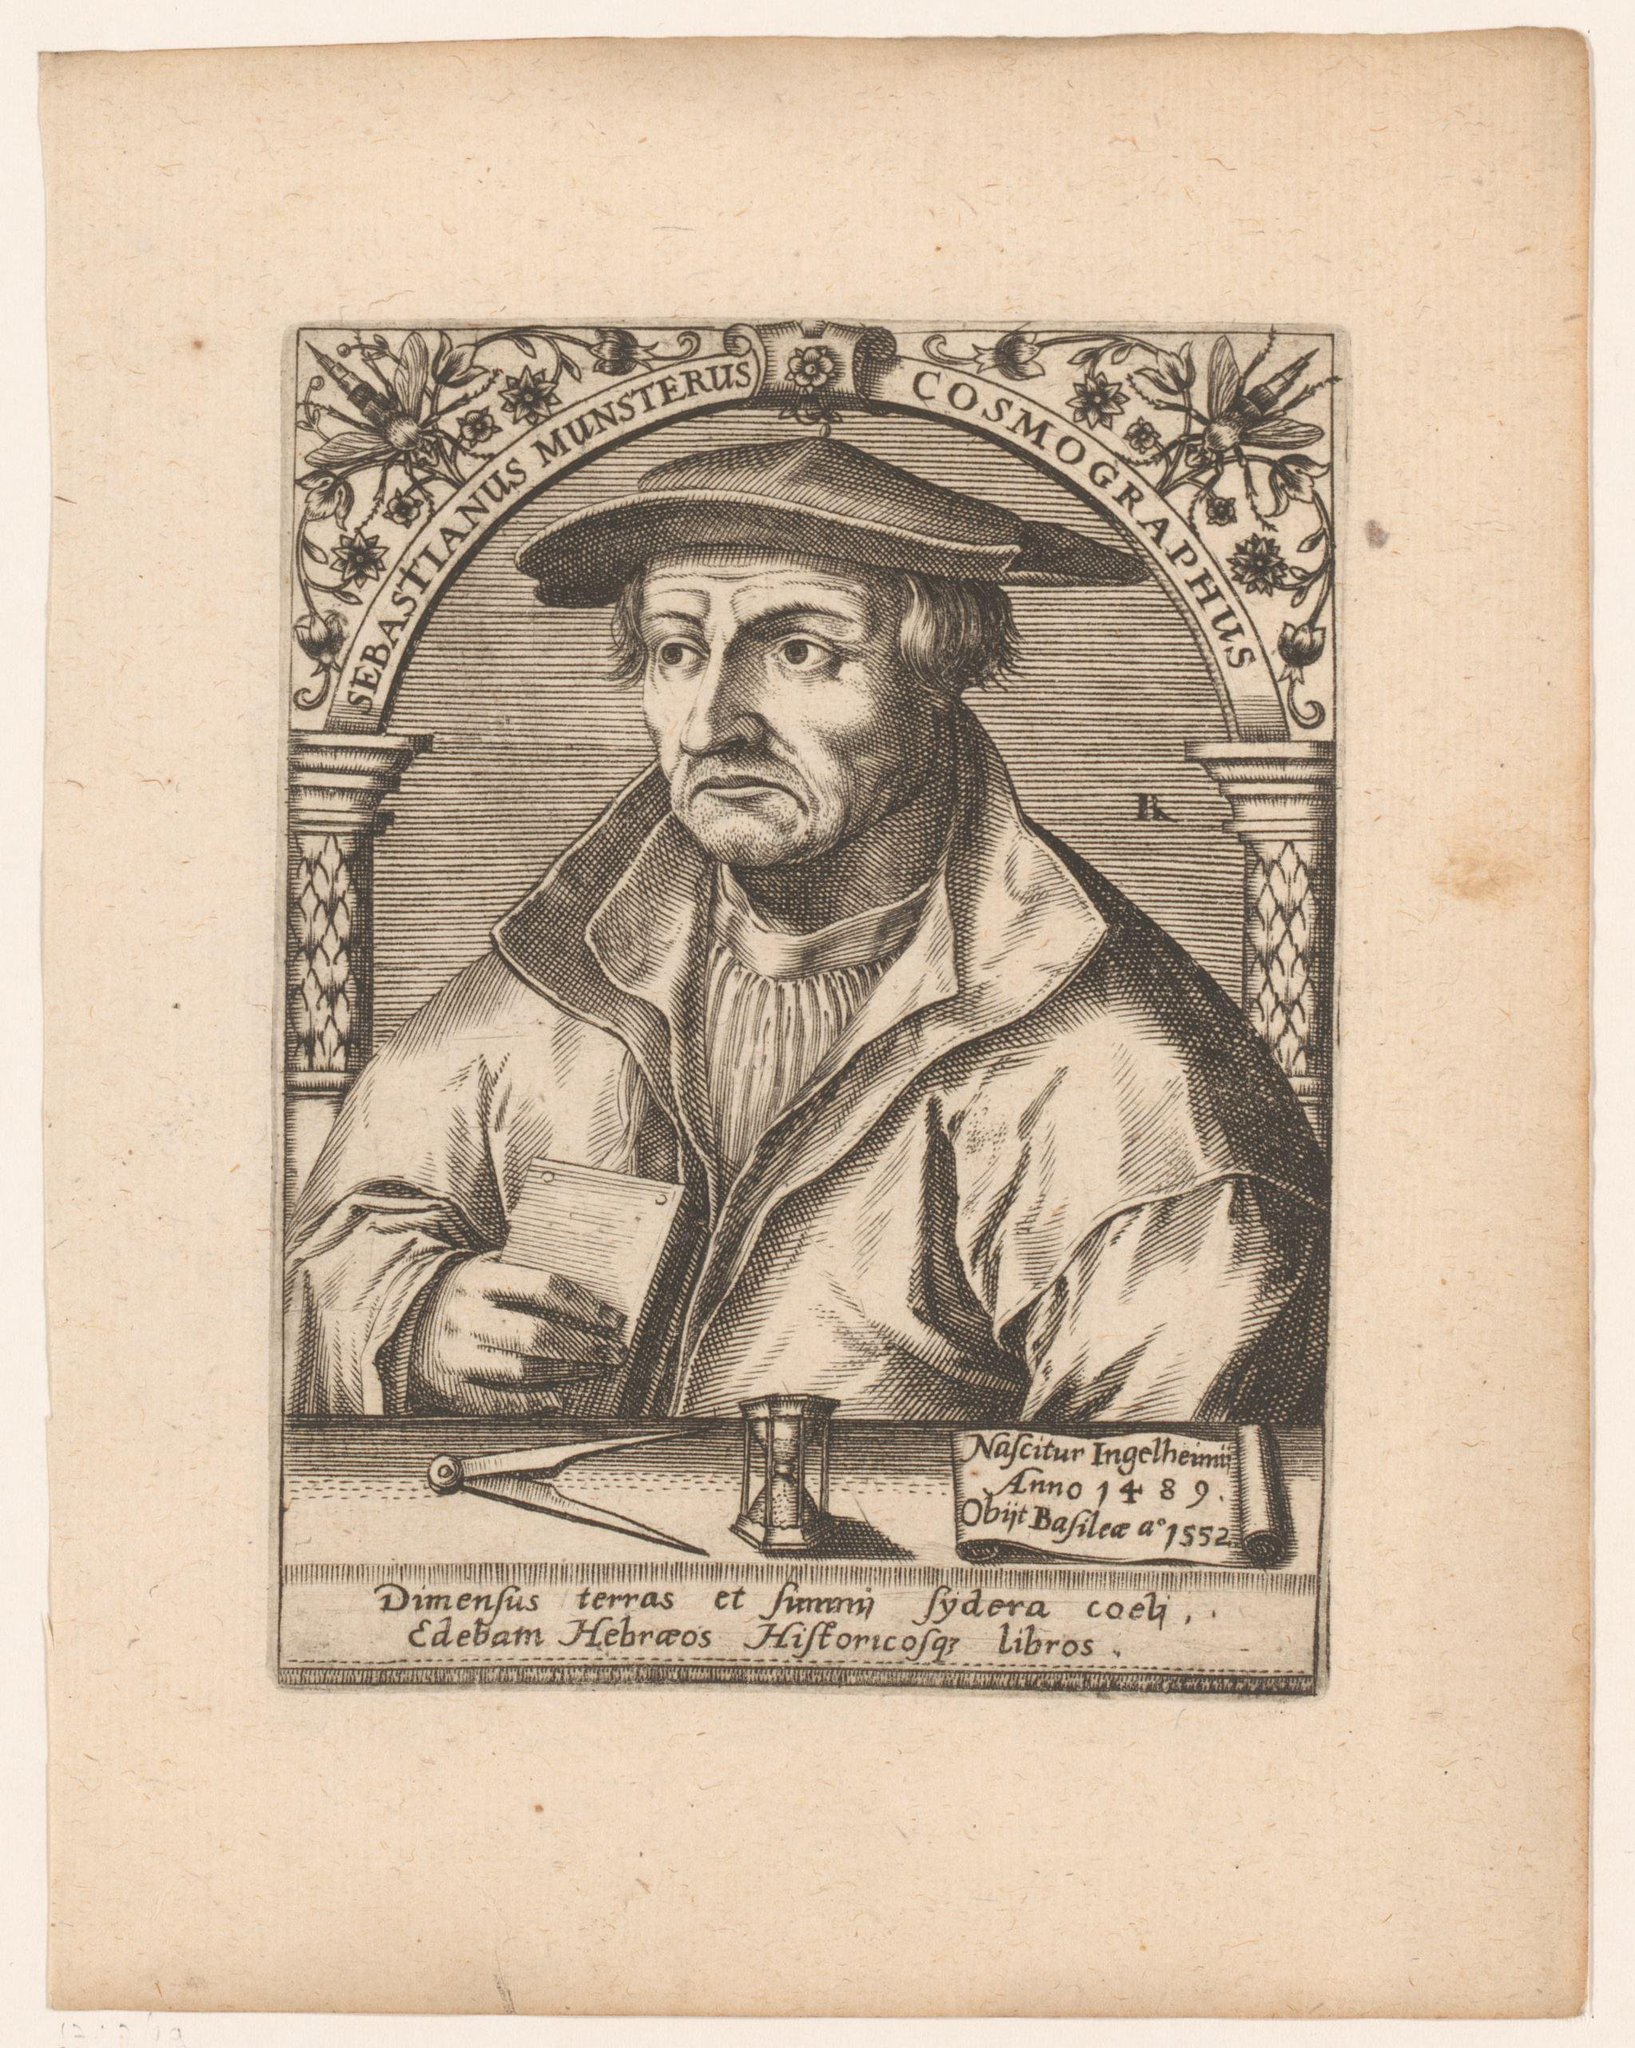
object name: print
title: Sebastianus Munsterus cosmographus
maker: robert boissard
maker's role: print maker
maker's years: 1570-1611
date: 1597-1599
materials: paper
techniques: engraving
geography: france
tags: historical persons, book, hourglass, insects: fly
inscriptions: collector's mark: Lugt 2228